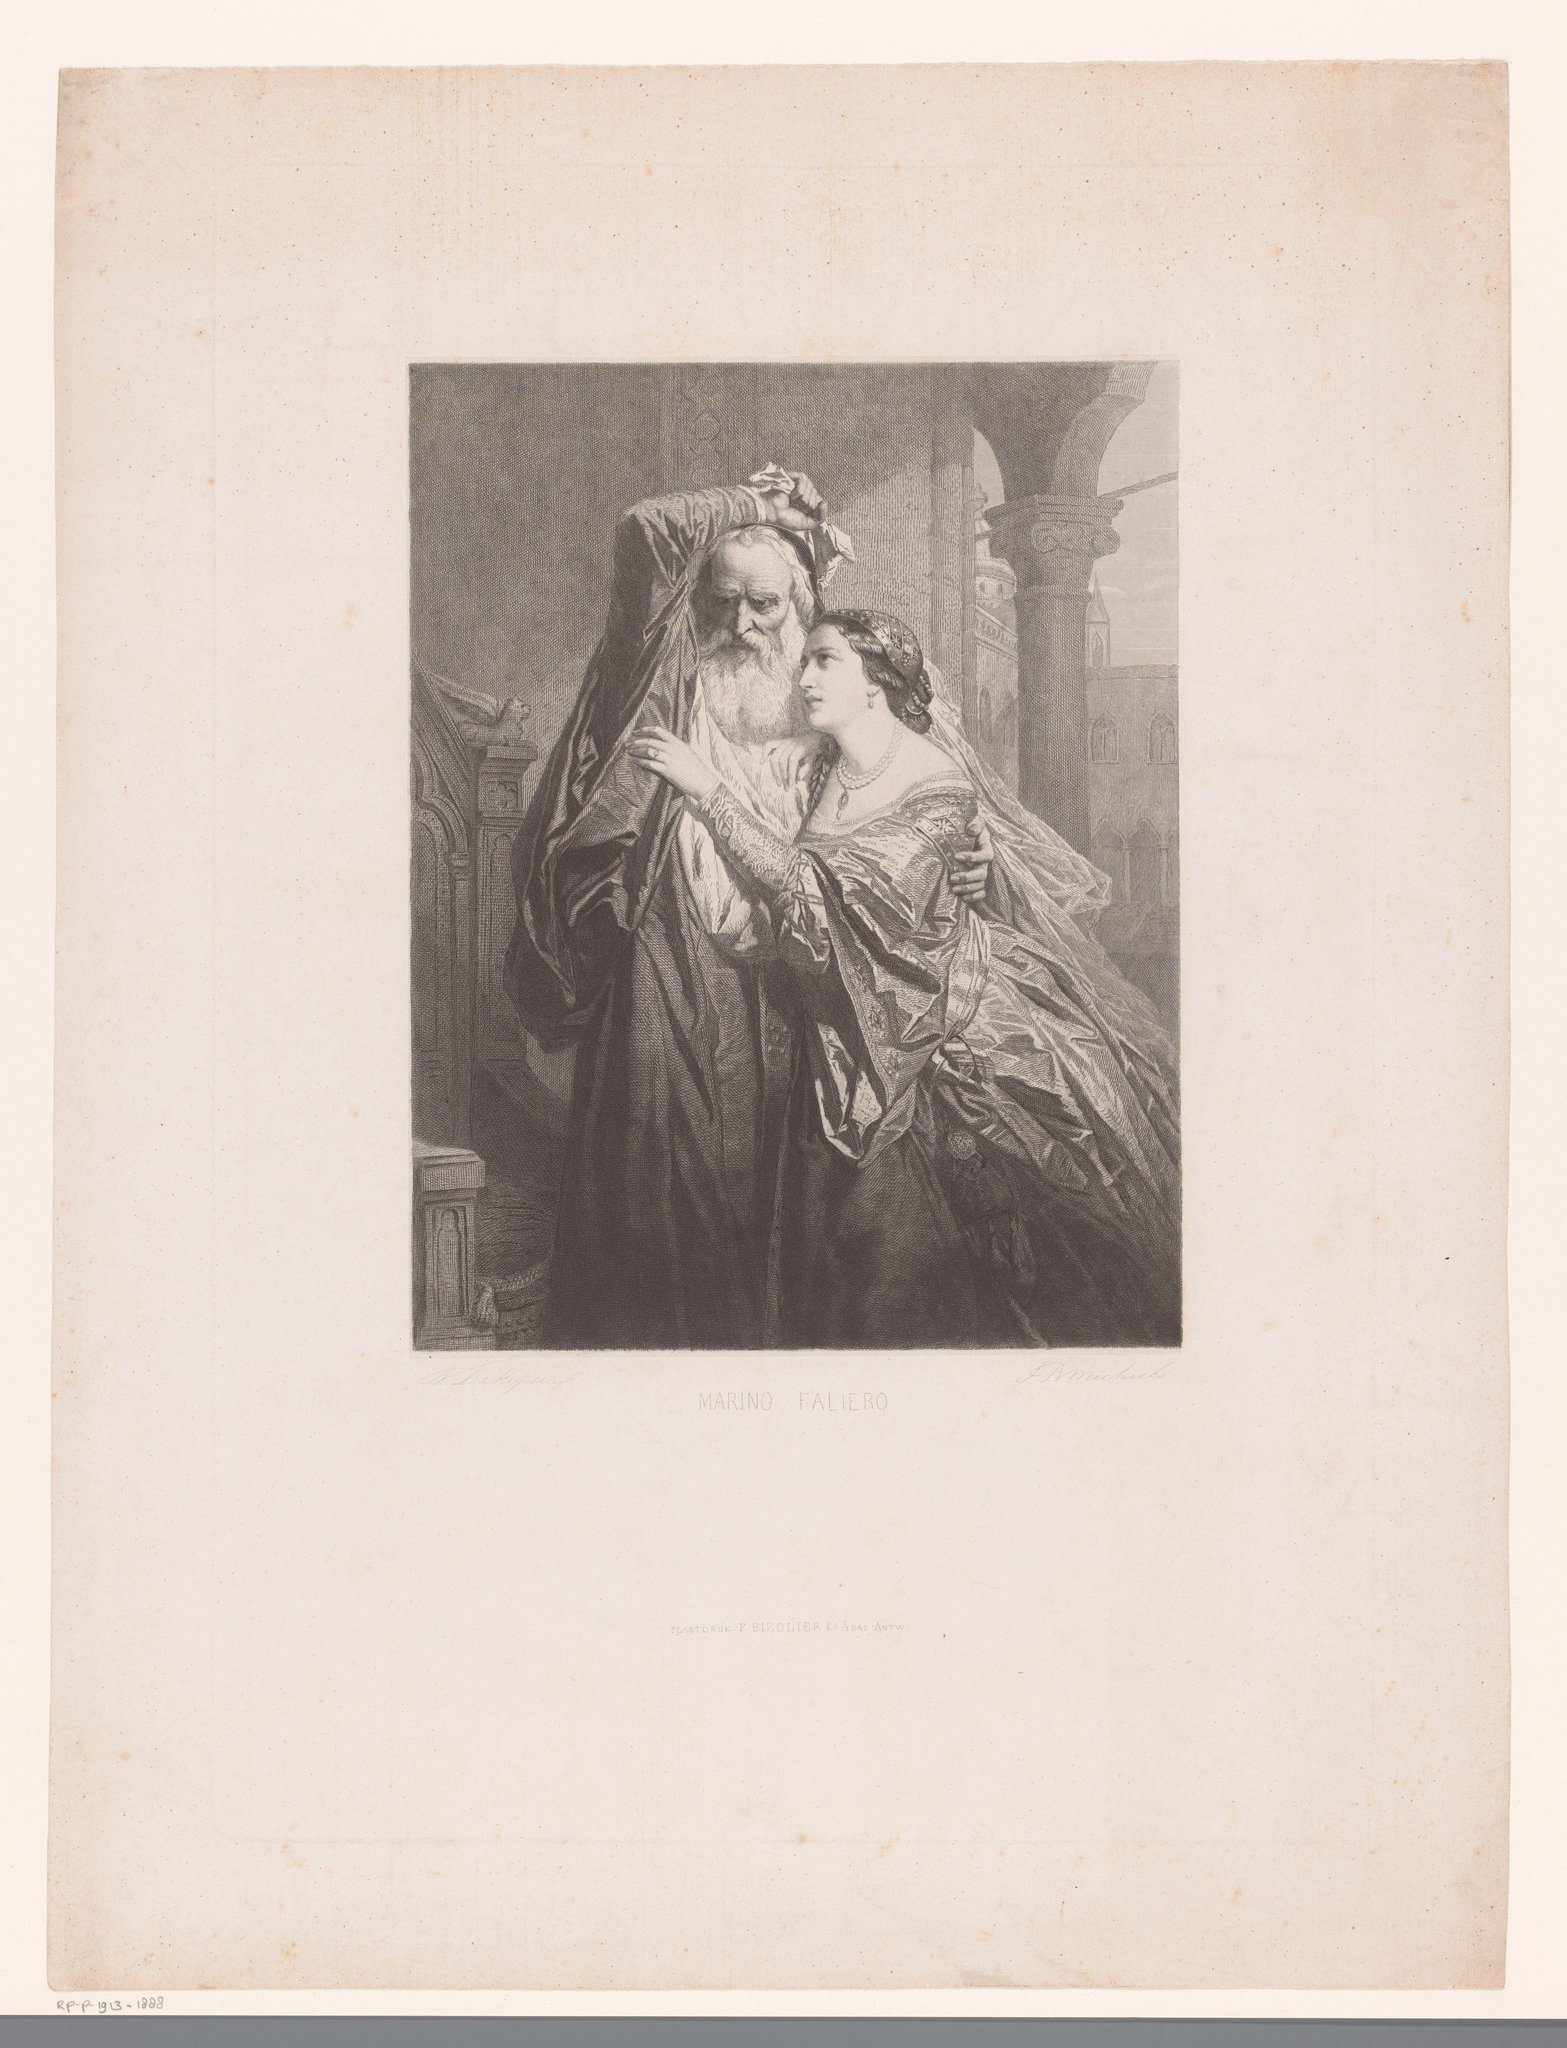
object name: print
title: Marino Faliero en zijn vrouw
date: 1831-1890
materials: paper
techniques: etching, intaglio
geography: antwerp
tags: venice, palace - aa - civic architecture: inside, adult woman, old man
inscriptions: collector's mark: Lugt 2228